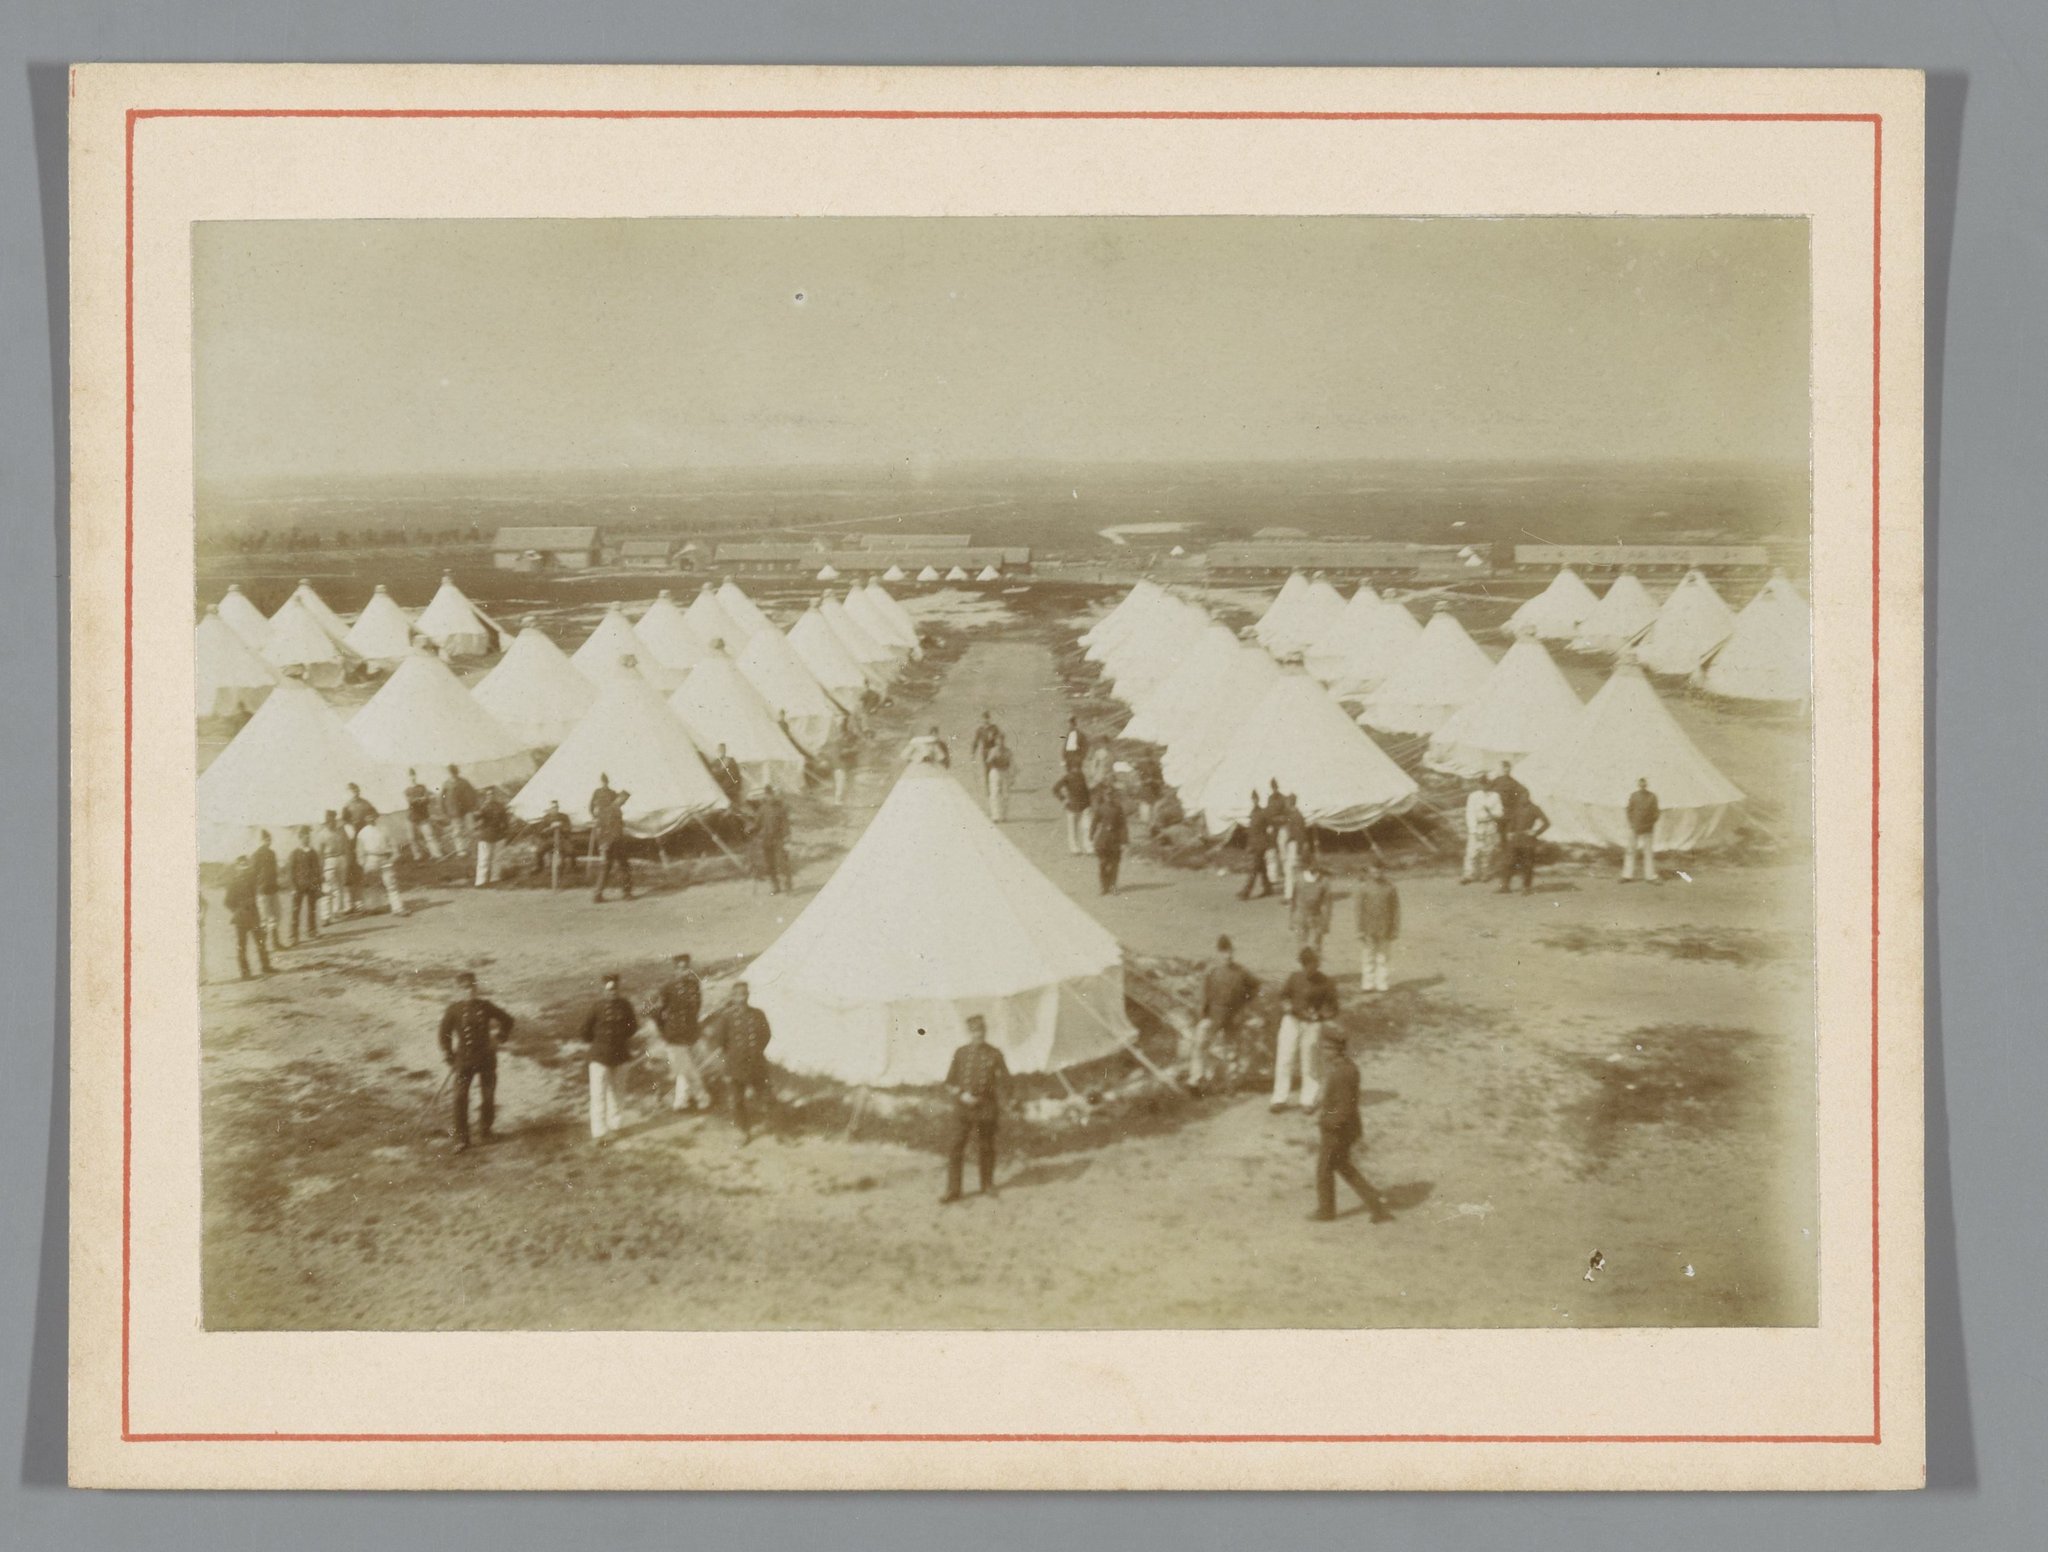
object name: photograph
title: Legerkamp bij Oldebroek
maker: karel alexander enklaar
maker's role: fotograaf, luitenant, militair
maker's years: 1858-1943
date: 1890-1895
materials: paper, cardboard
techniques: collodion silver print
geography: oldebroek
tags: (military) camp with tents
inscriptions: collector's mark: ‘Vosmaer’, inscription: ‘Legerplaats bij Oldebroek/ gefot. door Enklaar’